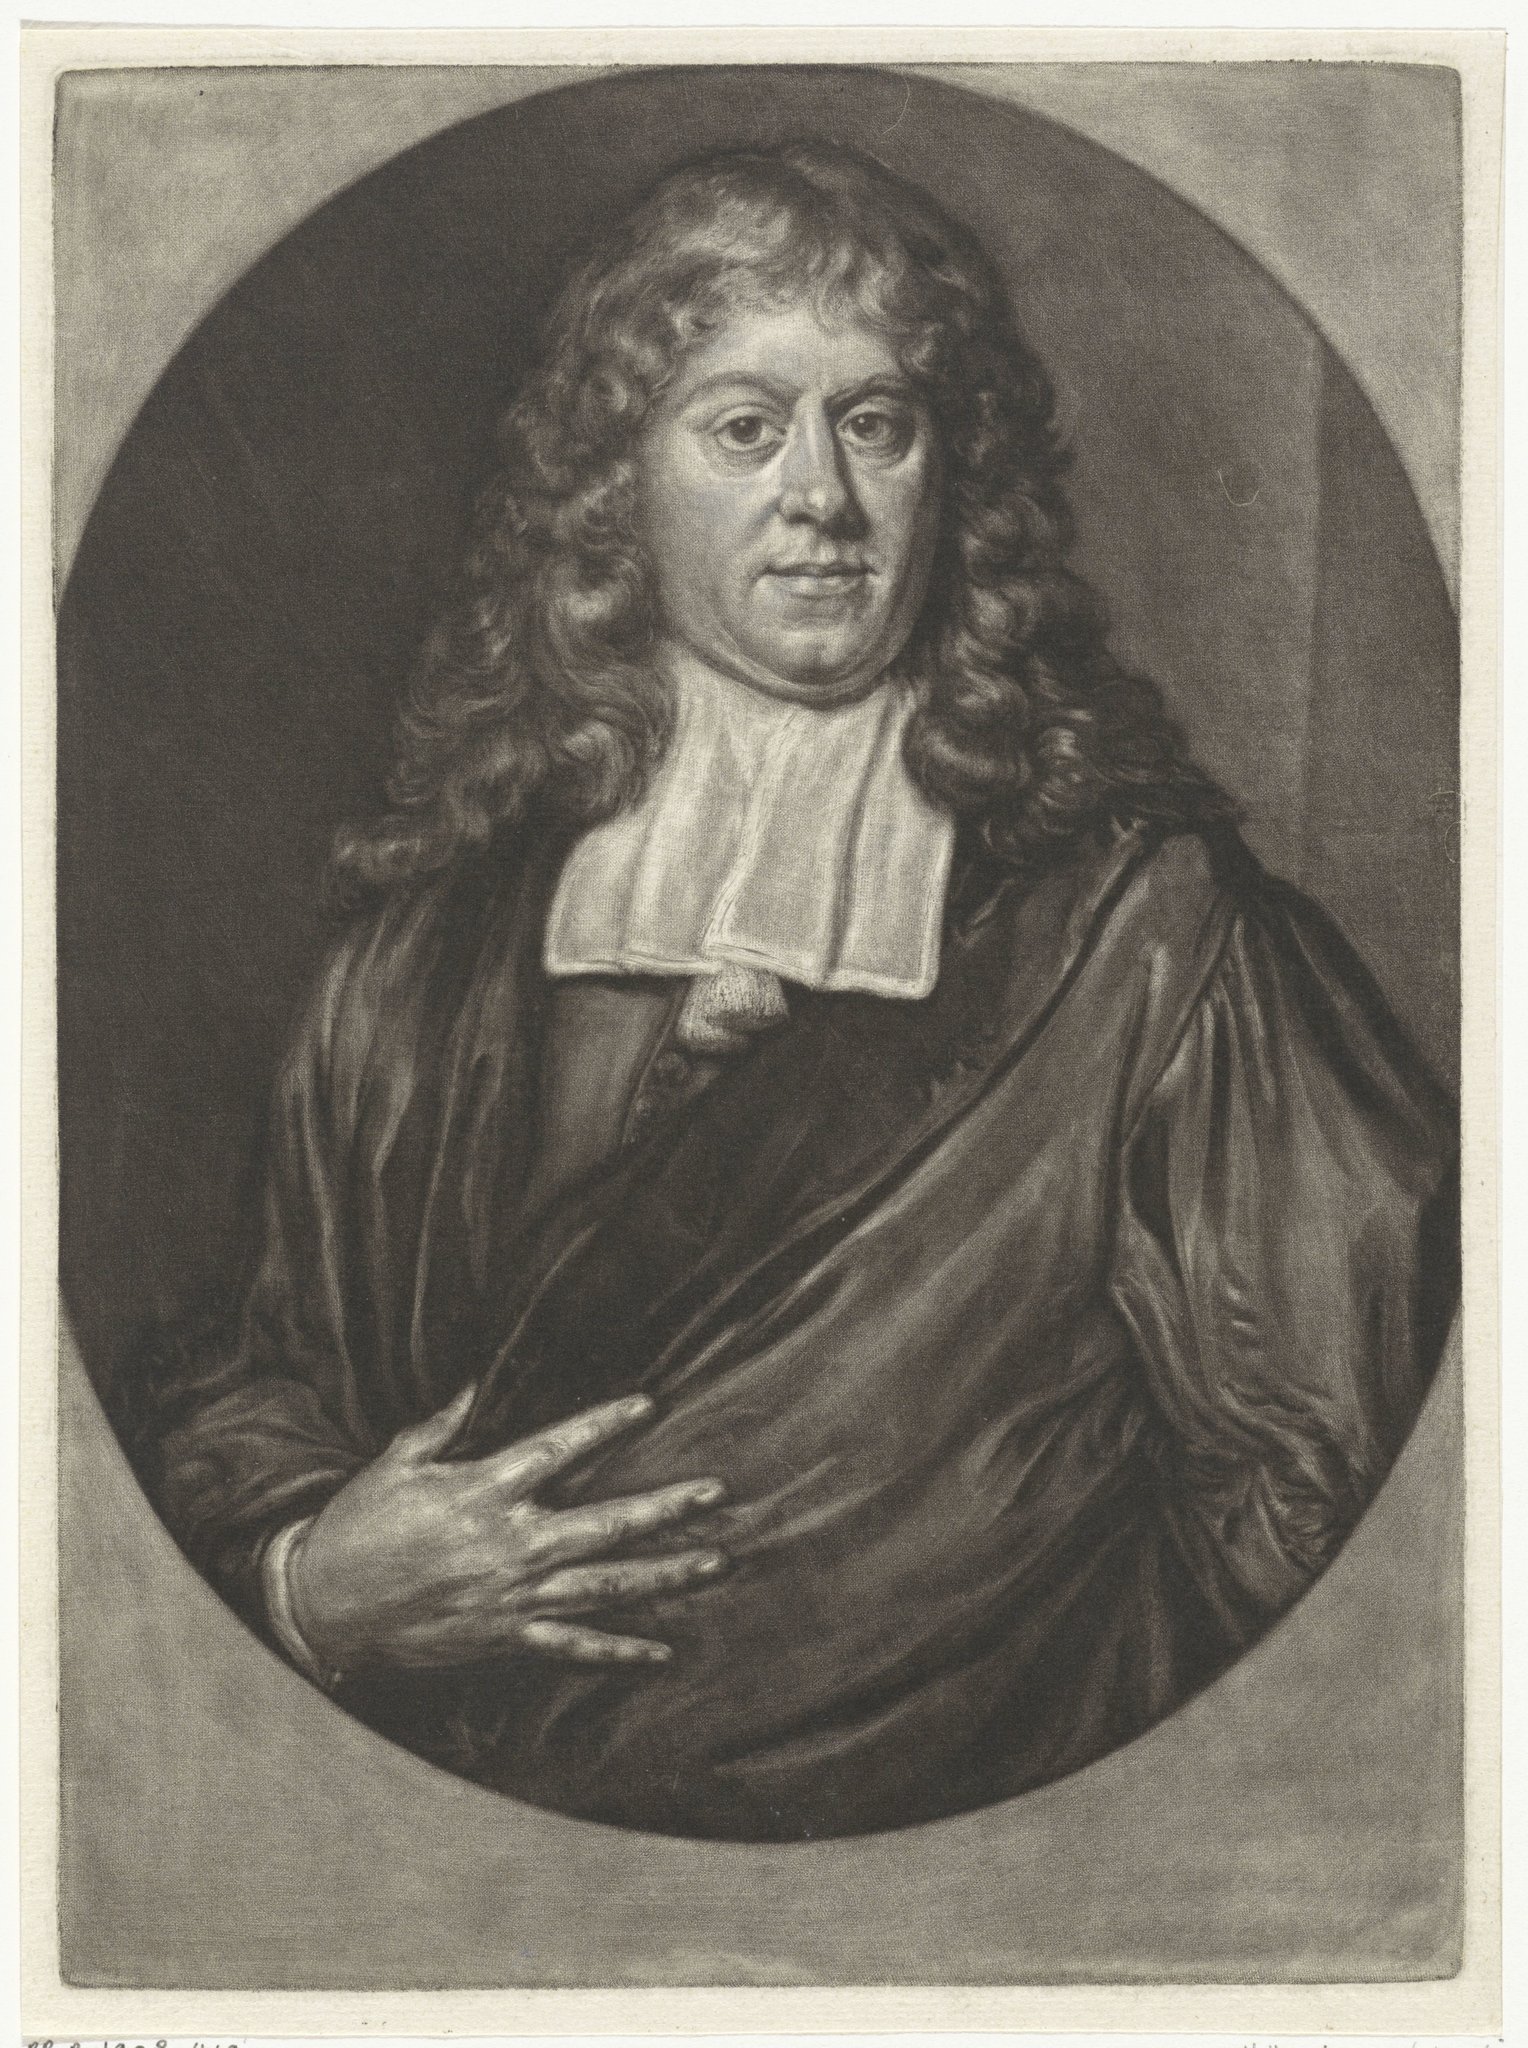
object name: print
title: Portret van Gerbrand van Leeuwen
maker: pieter van der plas (ii)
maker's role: print maker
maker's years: 1647-1708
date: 1687-1708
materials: paper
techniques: mezzotint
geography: amsterdam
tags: theologian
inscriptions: collector's mark: Lugt 2228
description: De predikant en hoogleraar in de godgeleerdheid Gerbrand van Leeuwen.